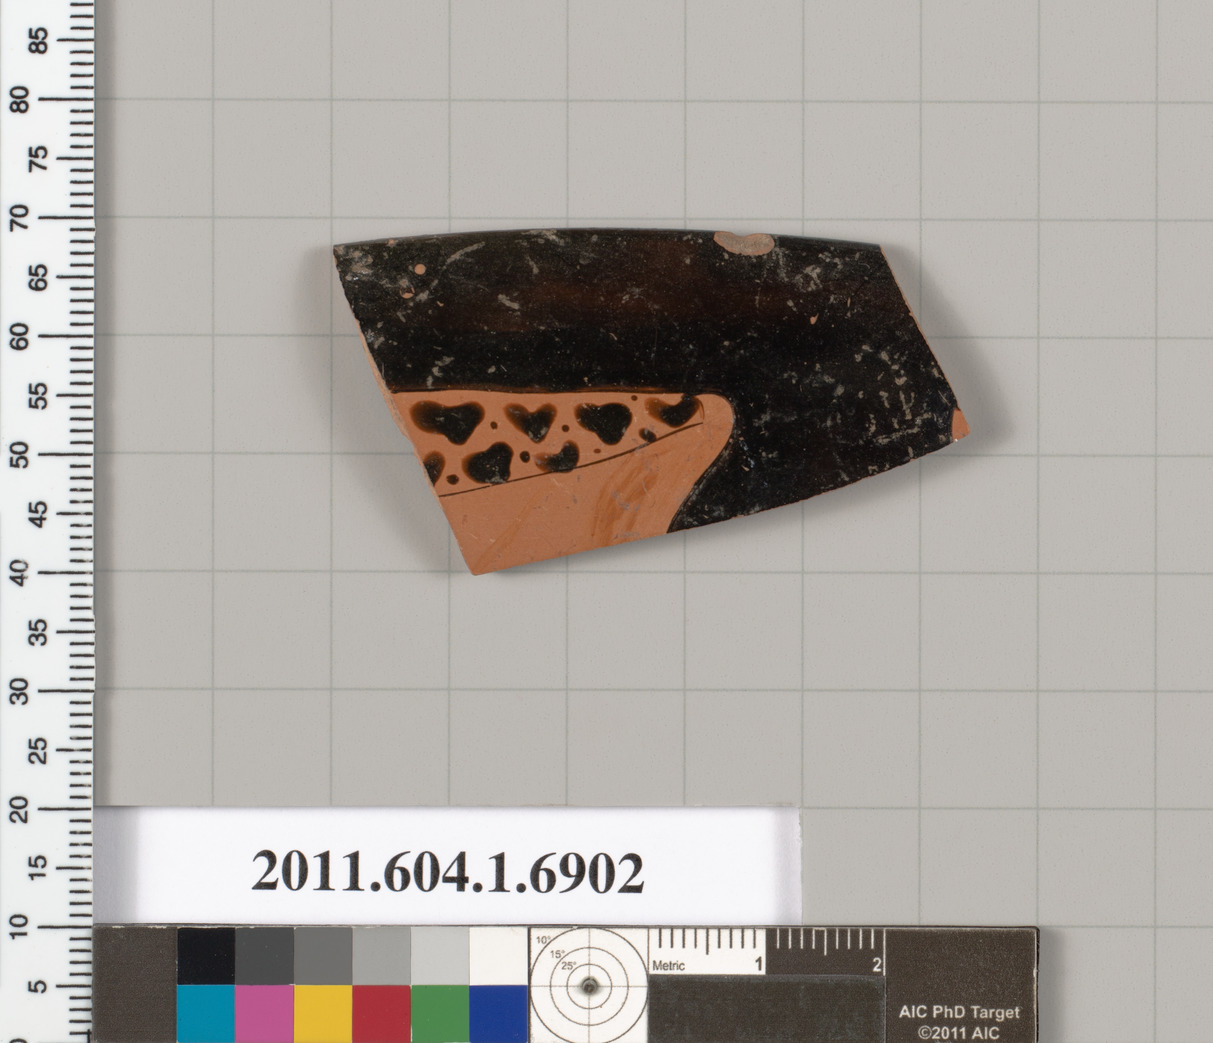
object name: kylix fragment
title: Terracotta rim fragment of a kylix (drinking cup)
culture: greek, attic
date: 490-470 BCE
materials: terracotta